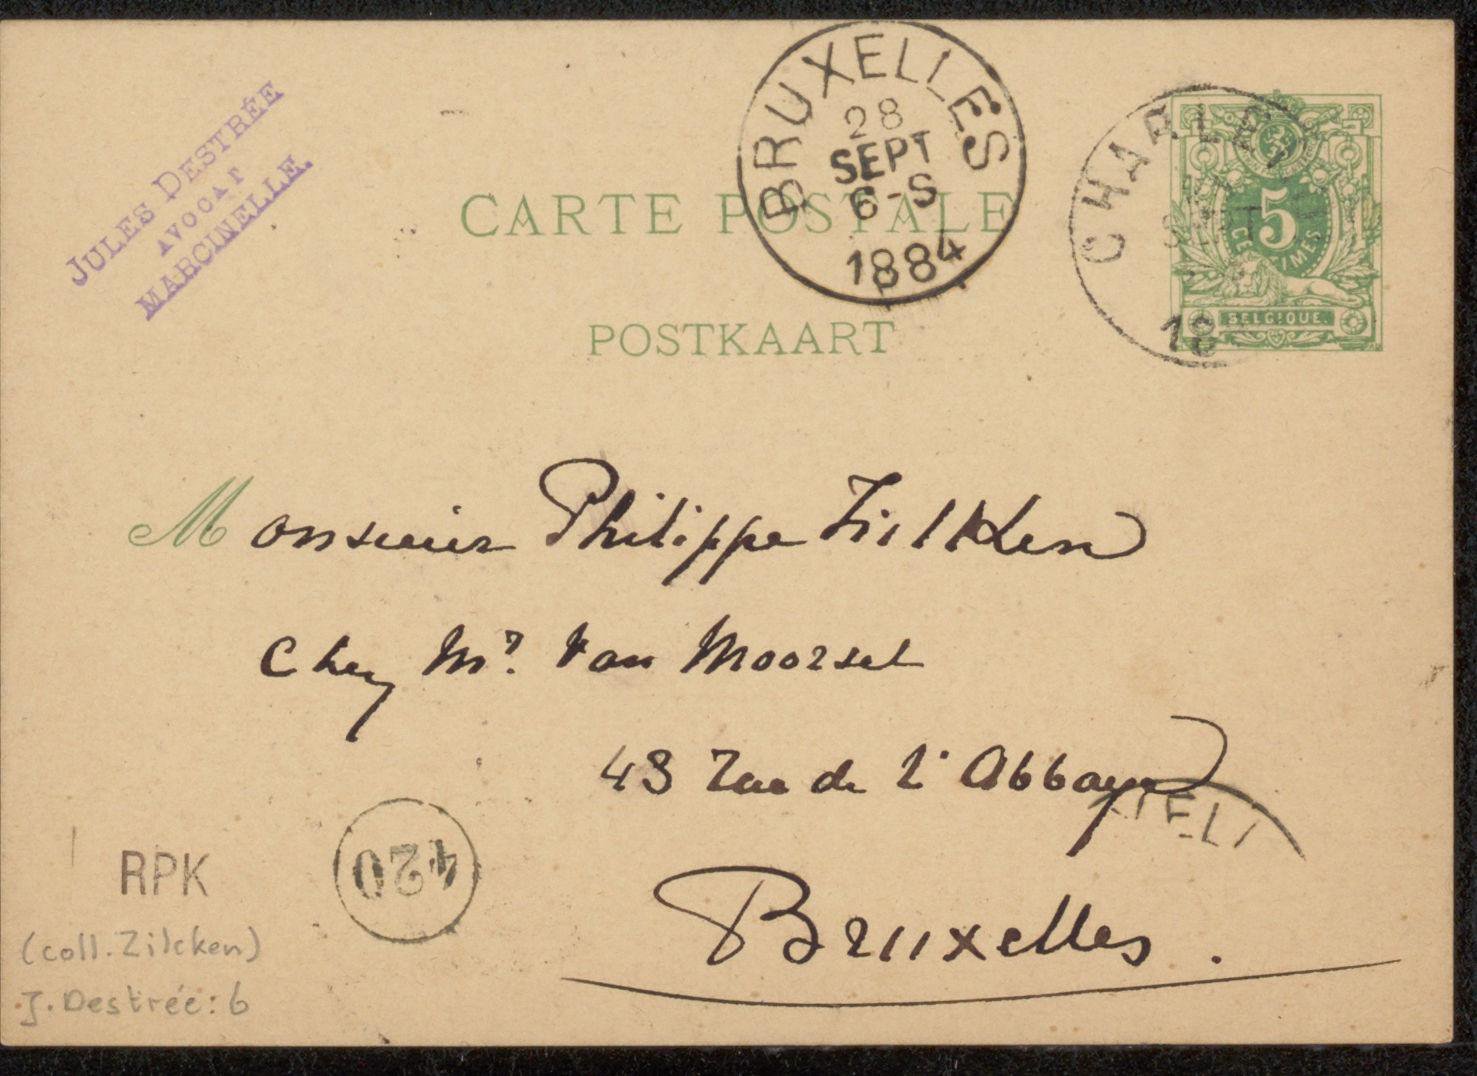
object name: postcard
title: Briefkaart aan Philip Zilcken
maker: jules destrée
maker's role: politician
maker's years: 1863-1936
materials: cardboard, ink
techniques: pen, writing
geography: charleroi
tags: painter, draughtsman, philip zilcken, brussels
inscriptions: name: ‘JULES DESTRÉE/ AVOCAT/ MARCINELLE.’, collector's mark: ‘RPK’